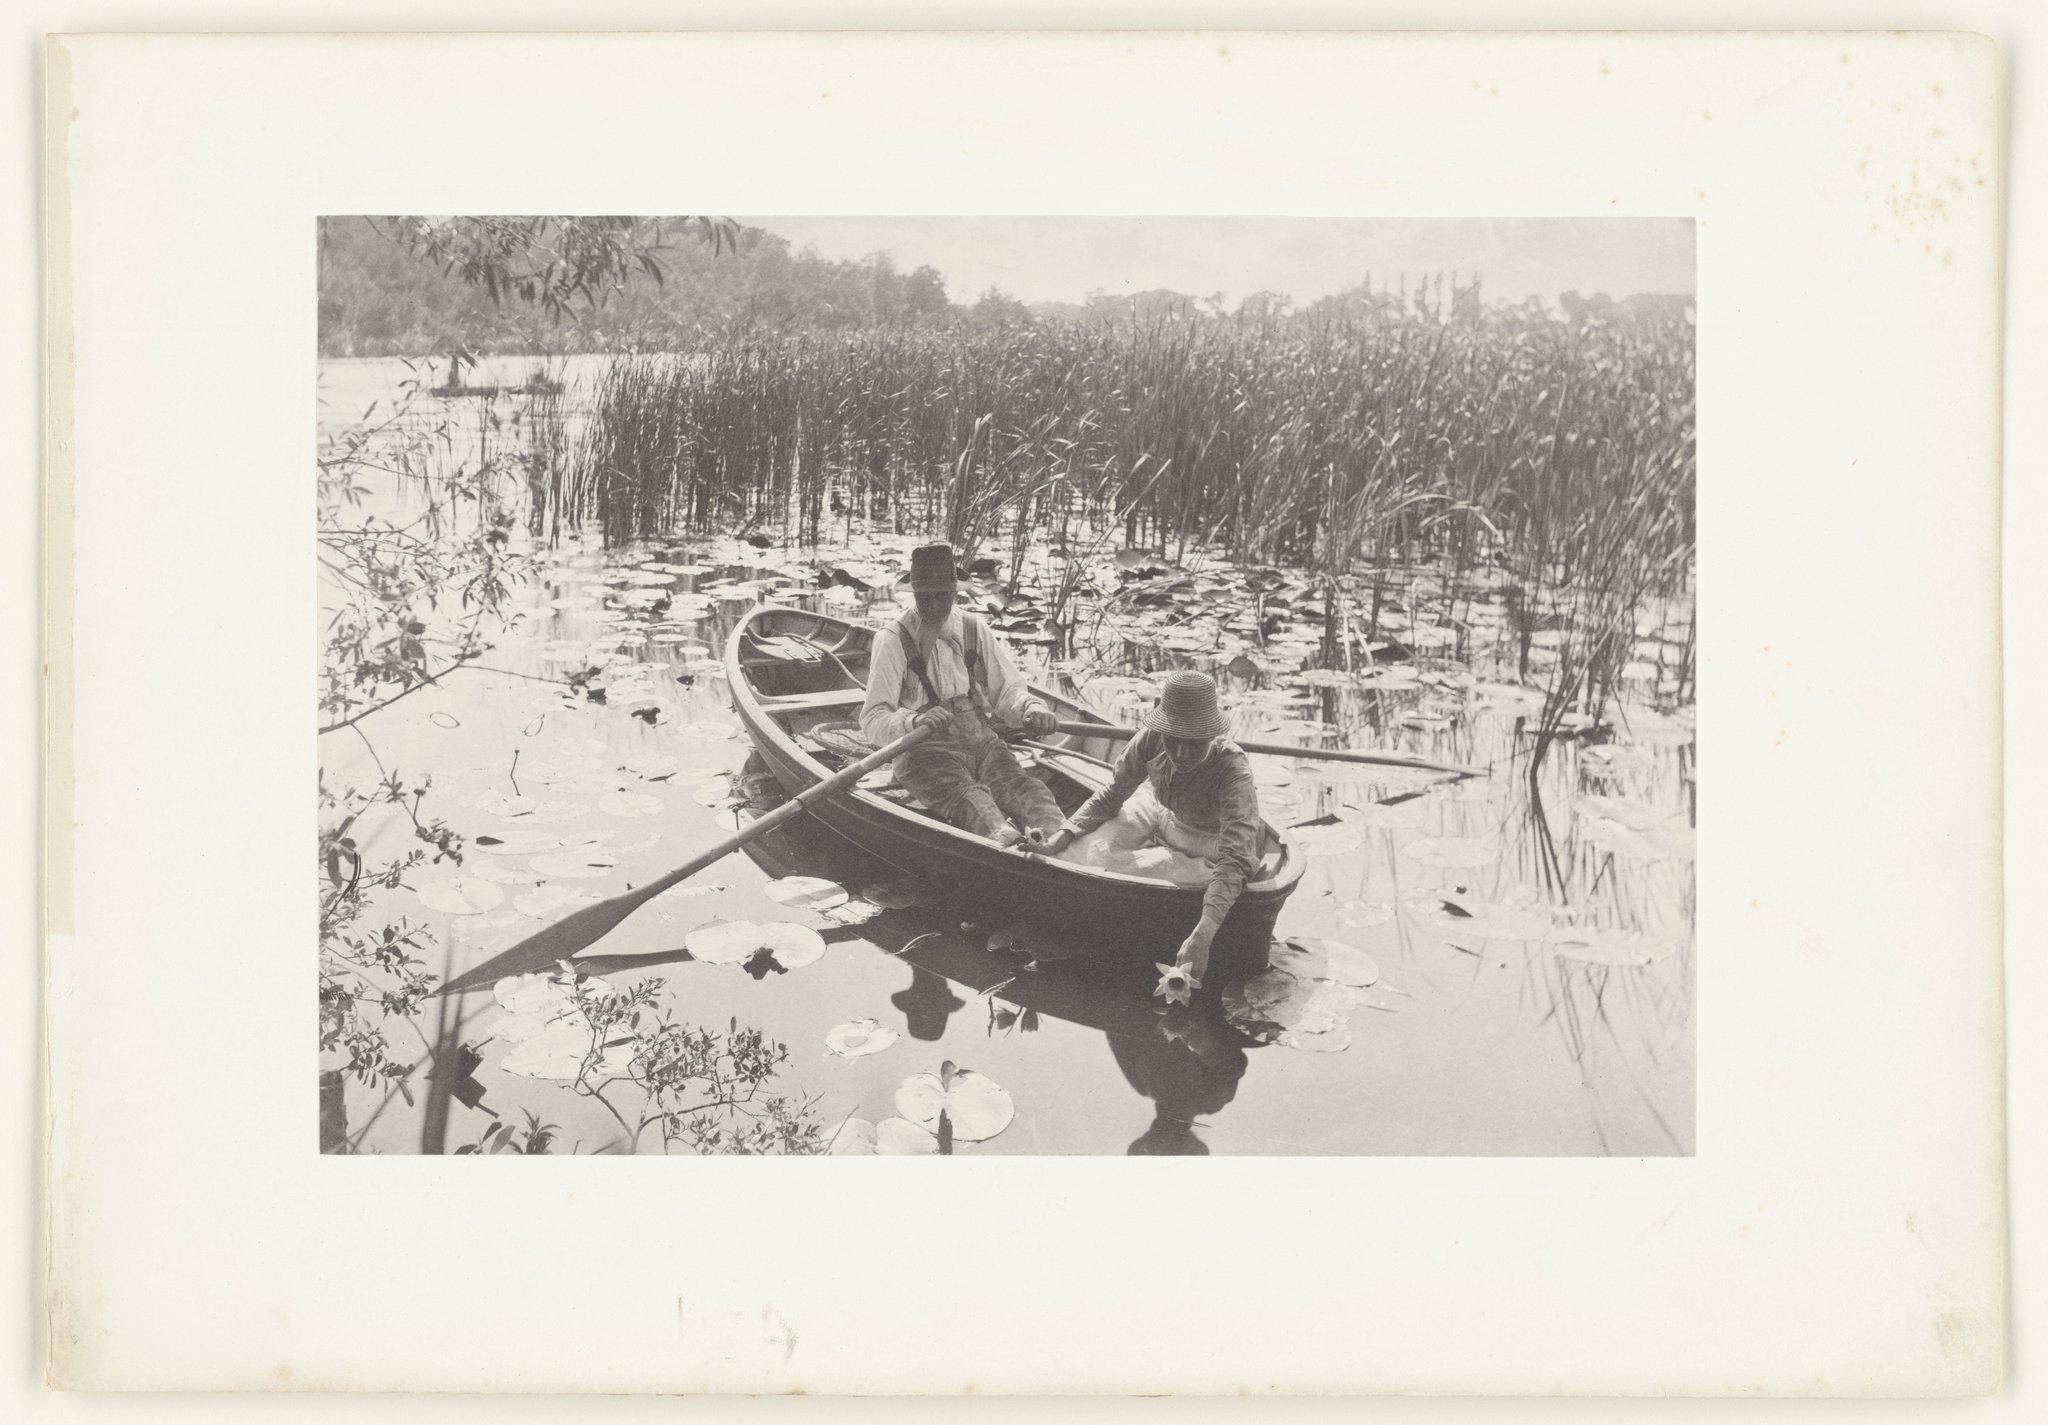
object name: photograph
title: Gathering Water-Lilies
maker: peter henry emerson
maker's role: fotograaf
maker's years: 1856-1936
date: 1885-1886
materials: cardboard, photographic support, paper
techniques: platinum process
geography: norfolk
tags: flowers: water-lily, rowing-boat, canoe, etc.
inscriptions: inscription: ‘Plate IX.’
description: Emerson made ten books of carefully composed photographs of the English countryside and its inhabitants between 1886 and 1895. These books were expensive, and printed in a small edition. Gathering Water-Lilies and A Rushy Shore both appeared in 1886 in Life and Landscape on the Norfolk Broads, which presented an idyllic image of this area.